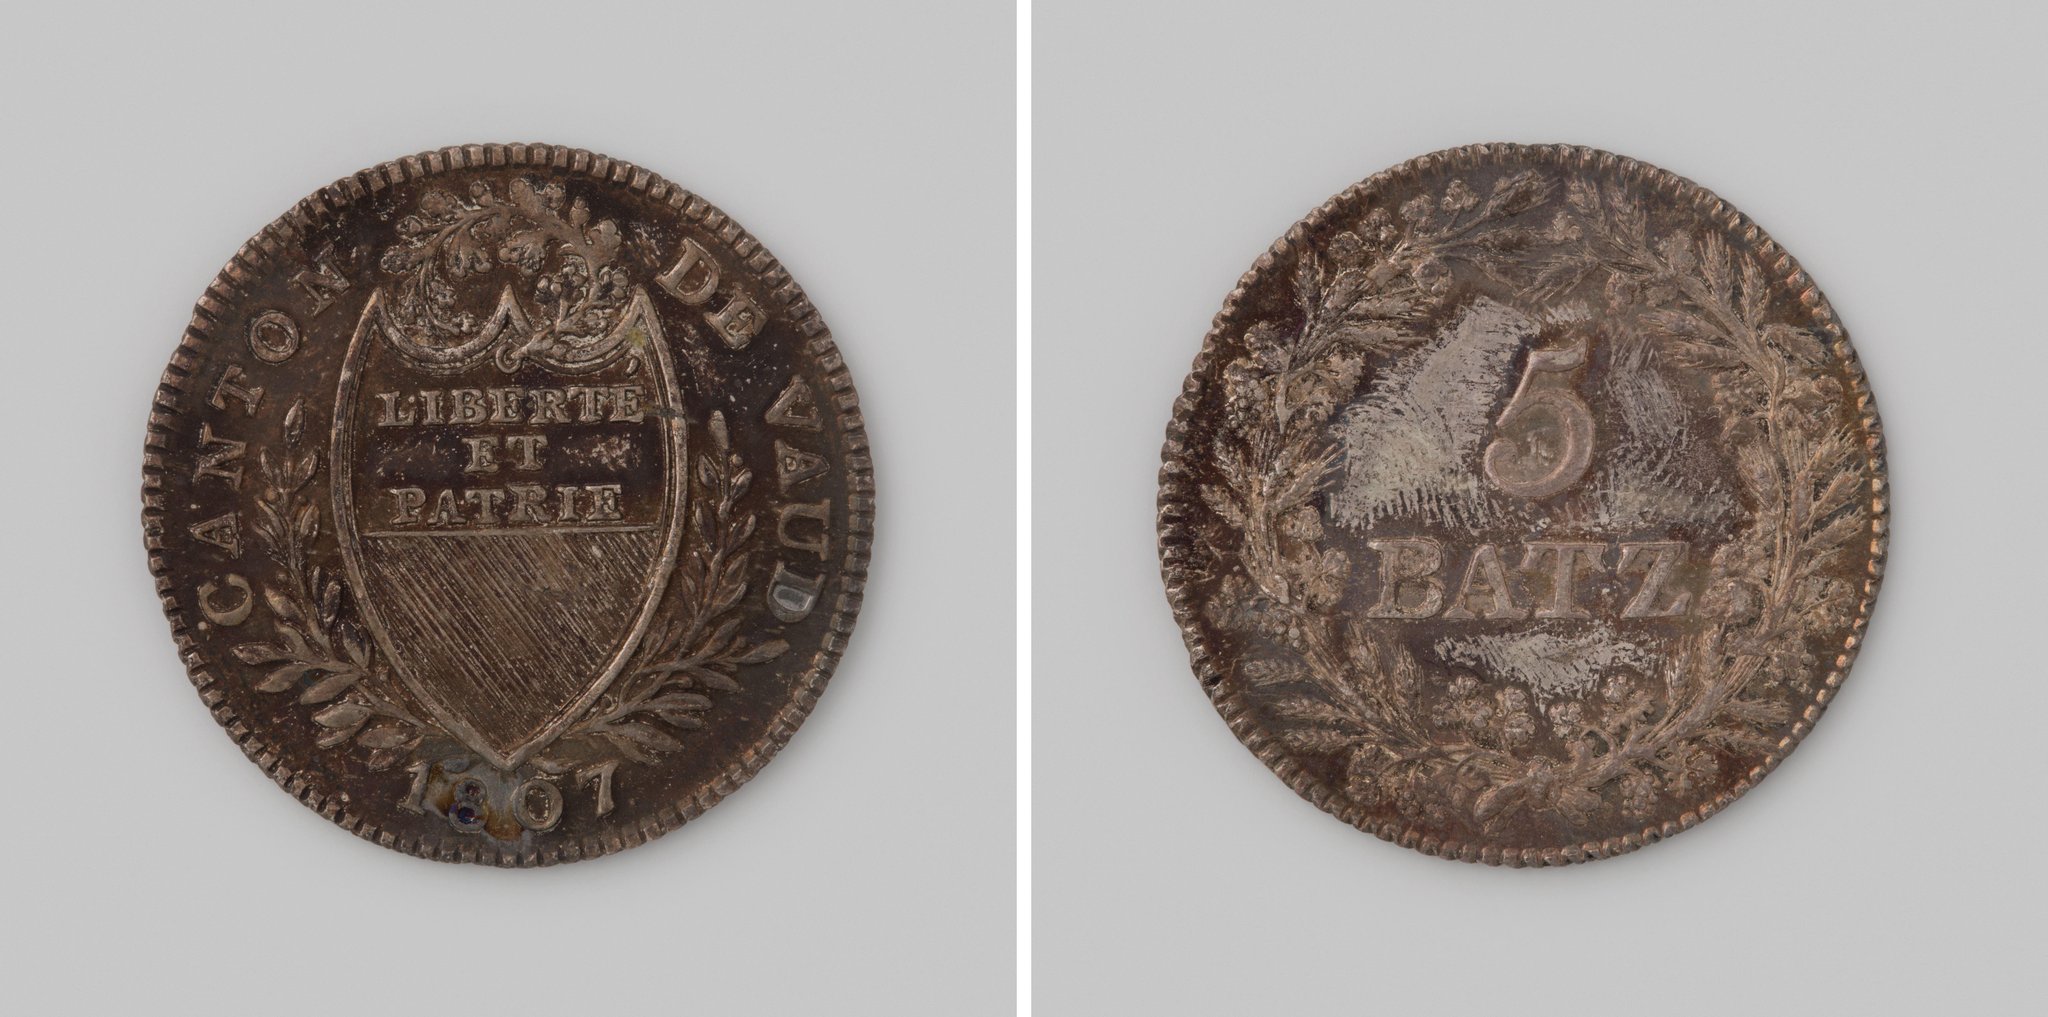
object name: coin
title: Kanton Vaud, 5 batz,1807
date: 1807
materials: silver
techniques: striking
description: Zilveren munt. Voorzijde: tussen twee takken wapenschild, waarboven rank. Jaartal onderaan in omschrift. Keerzijde: binnen twee samengebonden takken in twee regels waarde-aanduiding: 5 batz. Kabelrand.